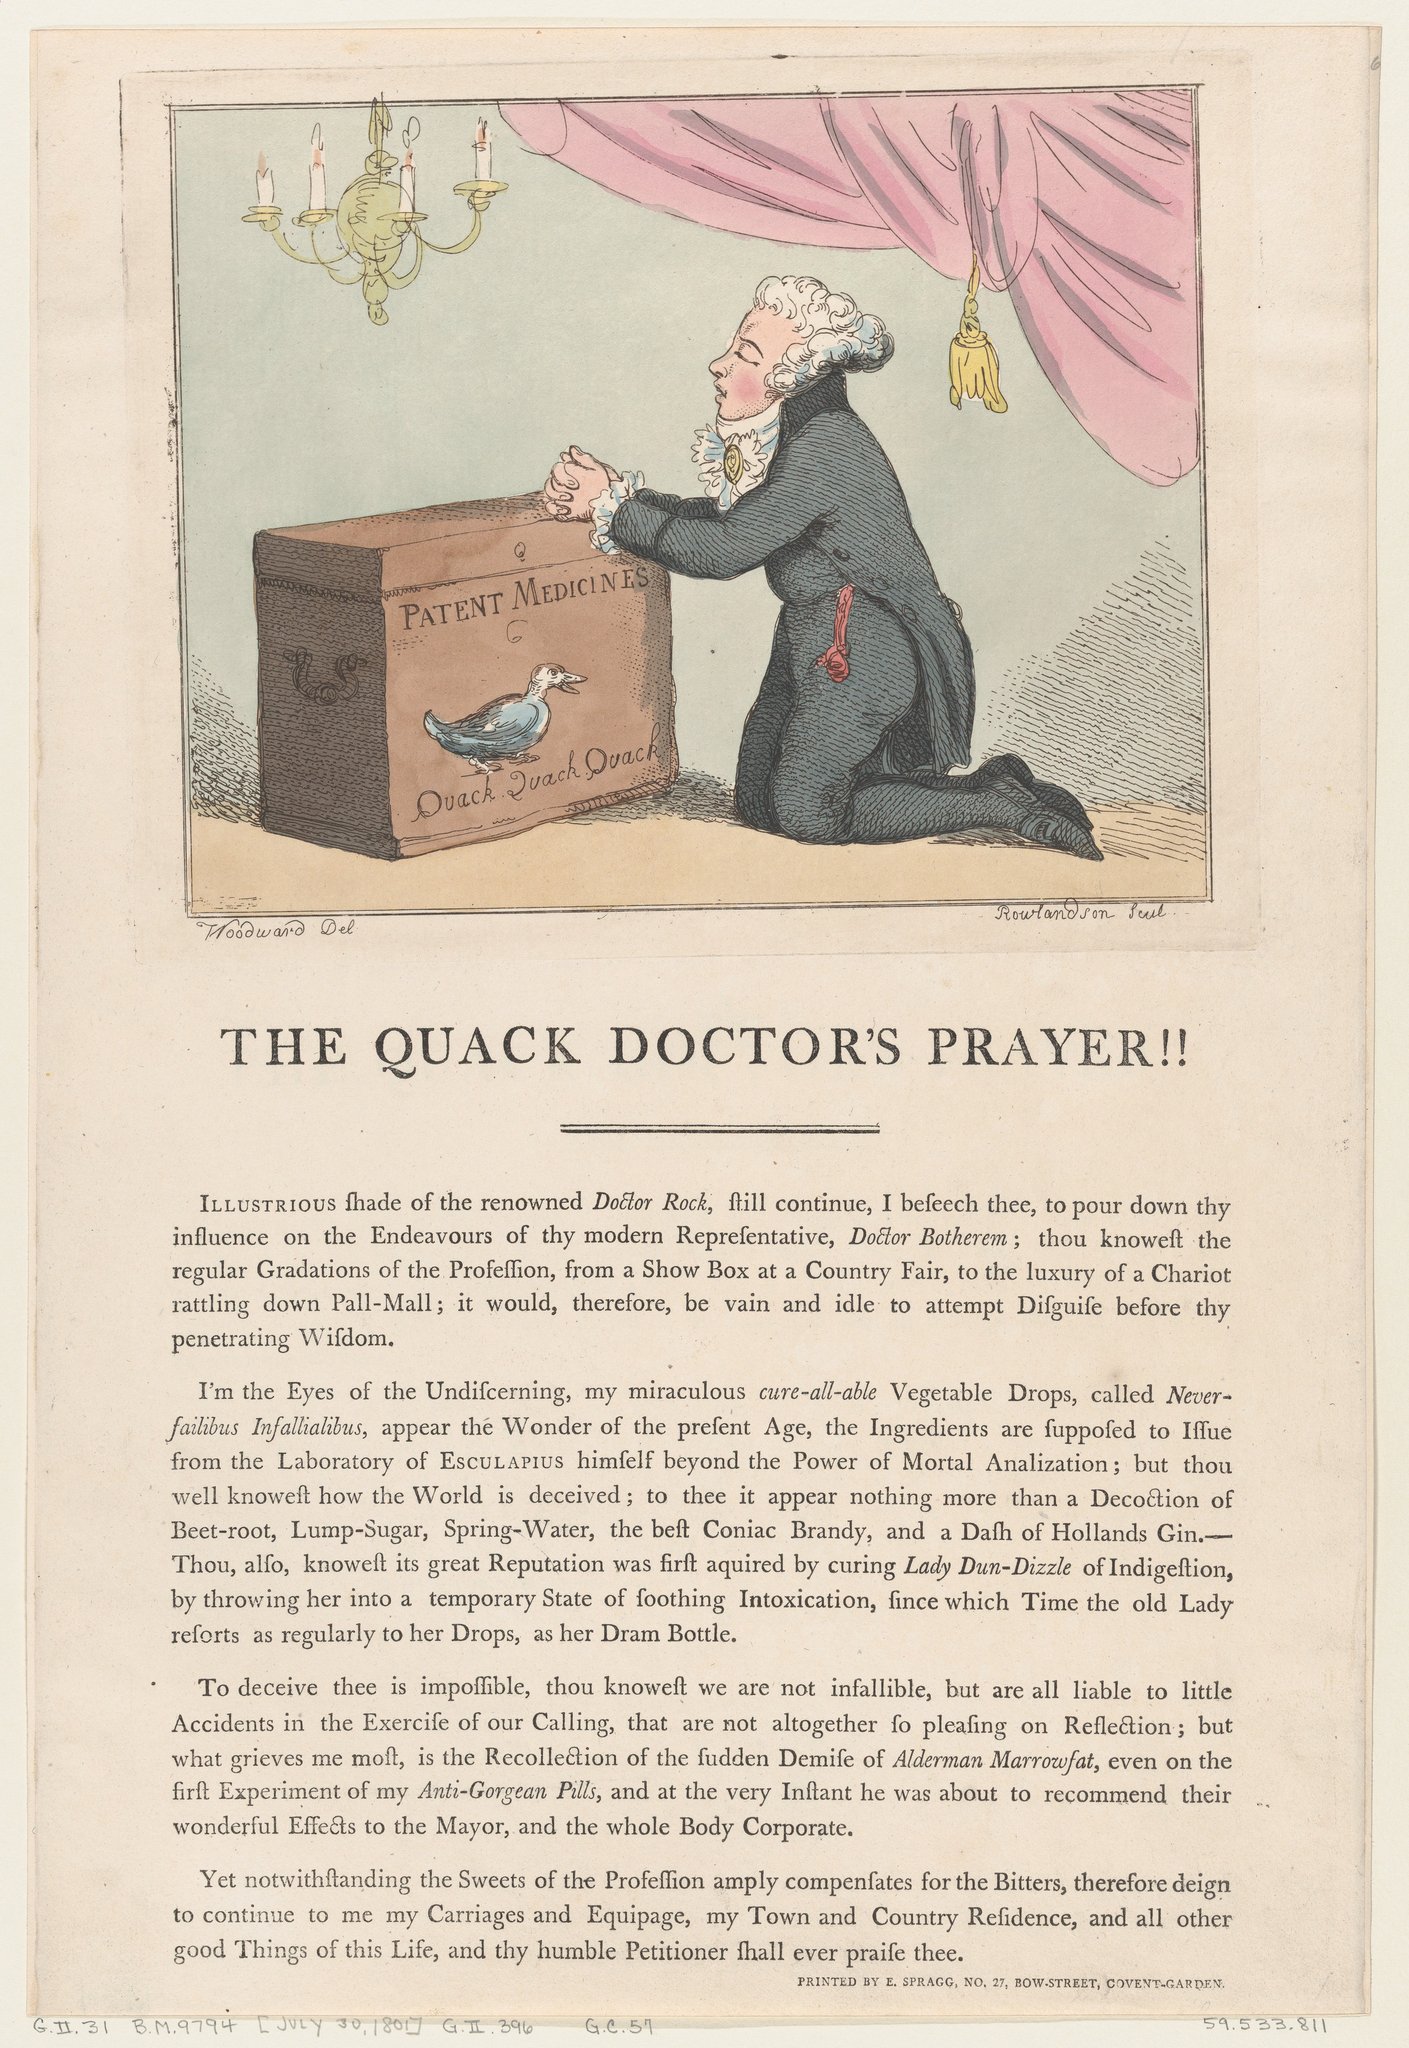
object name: print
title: The Quack Doctor's Prayer!!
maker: thomas rowlandson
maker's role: artist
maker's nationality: british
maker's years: 1757-1827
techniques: etching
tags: ducks,satire,men